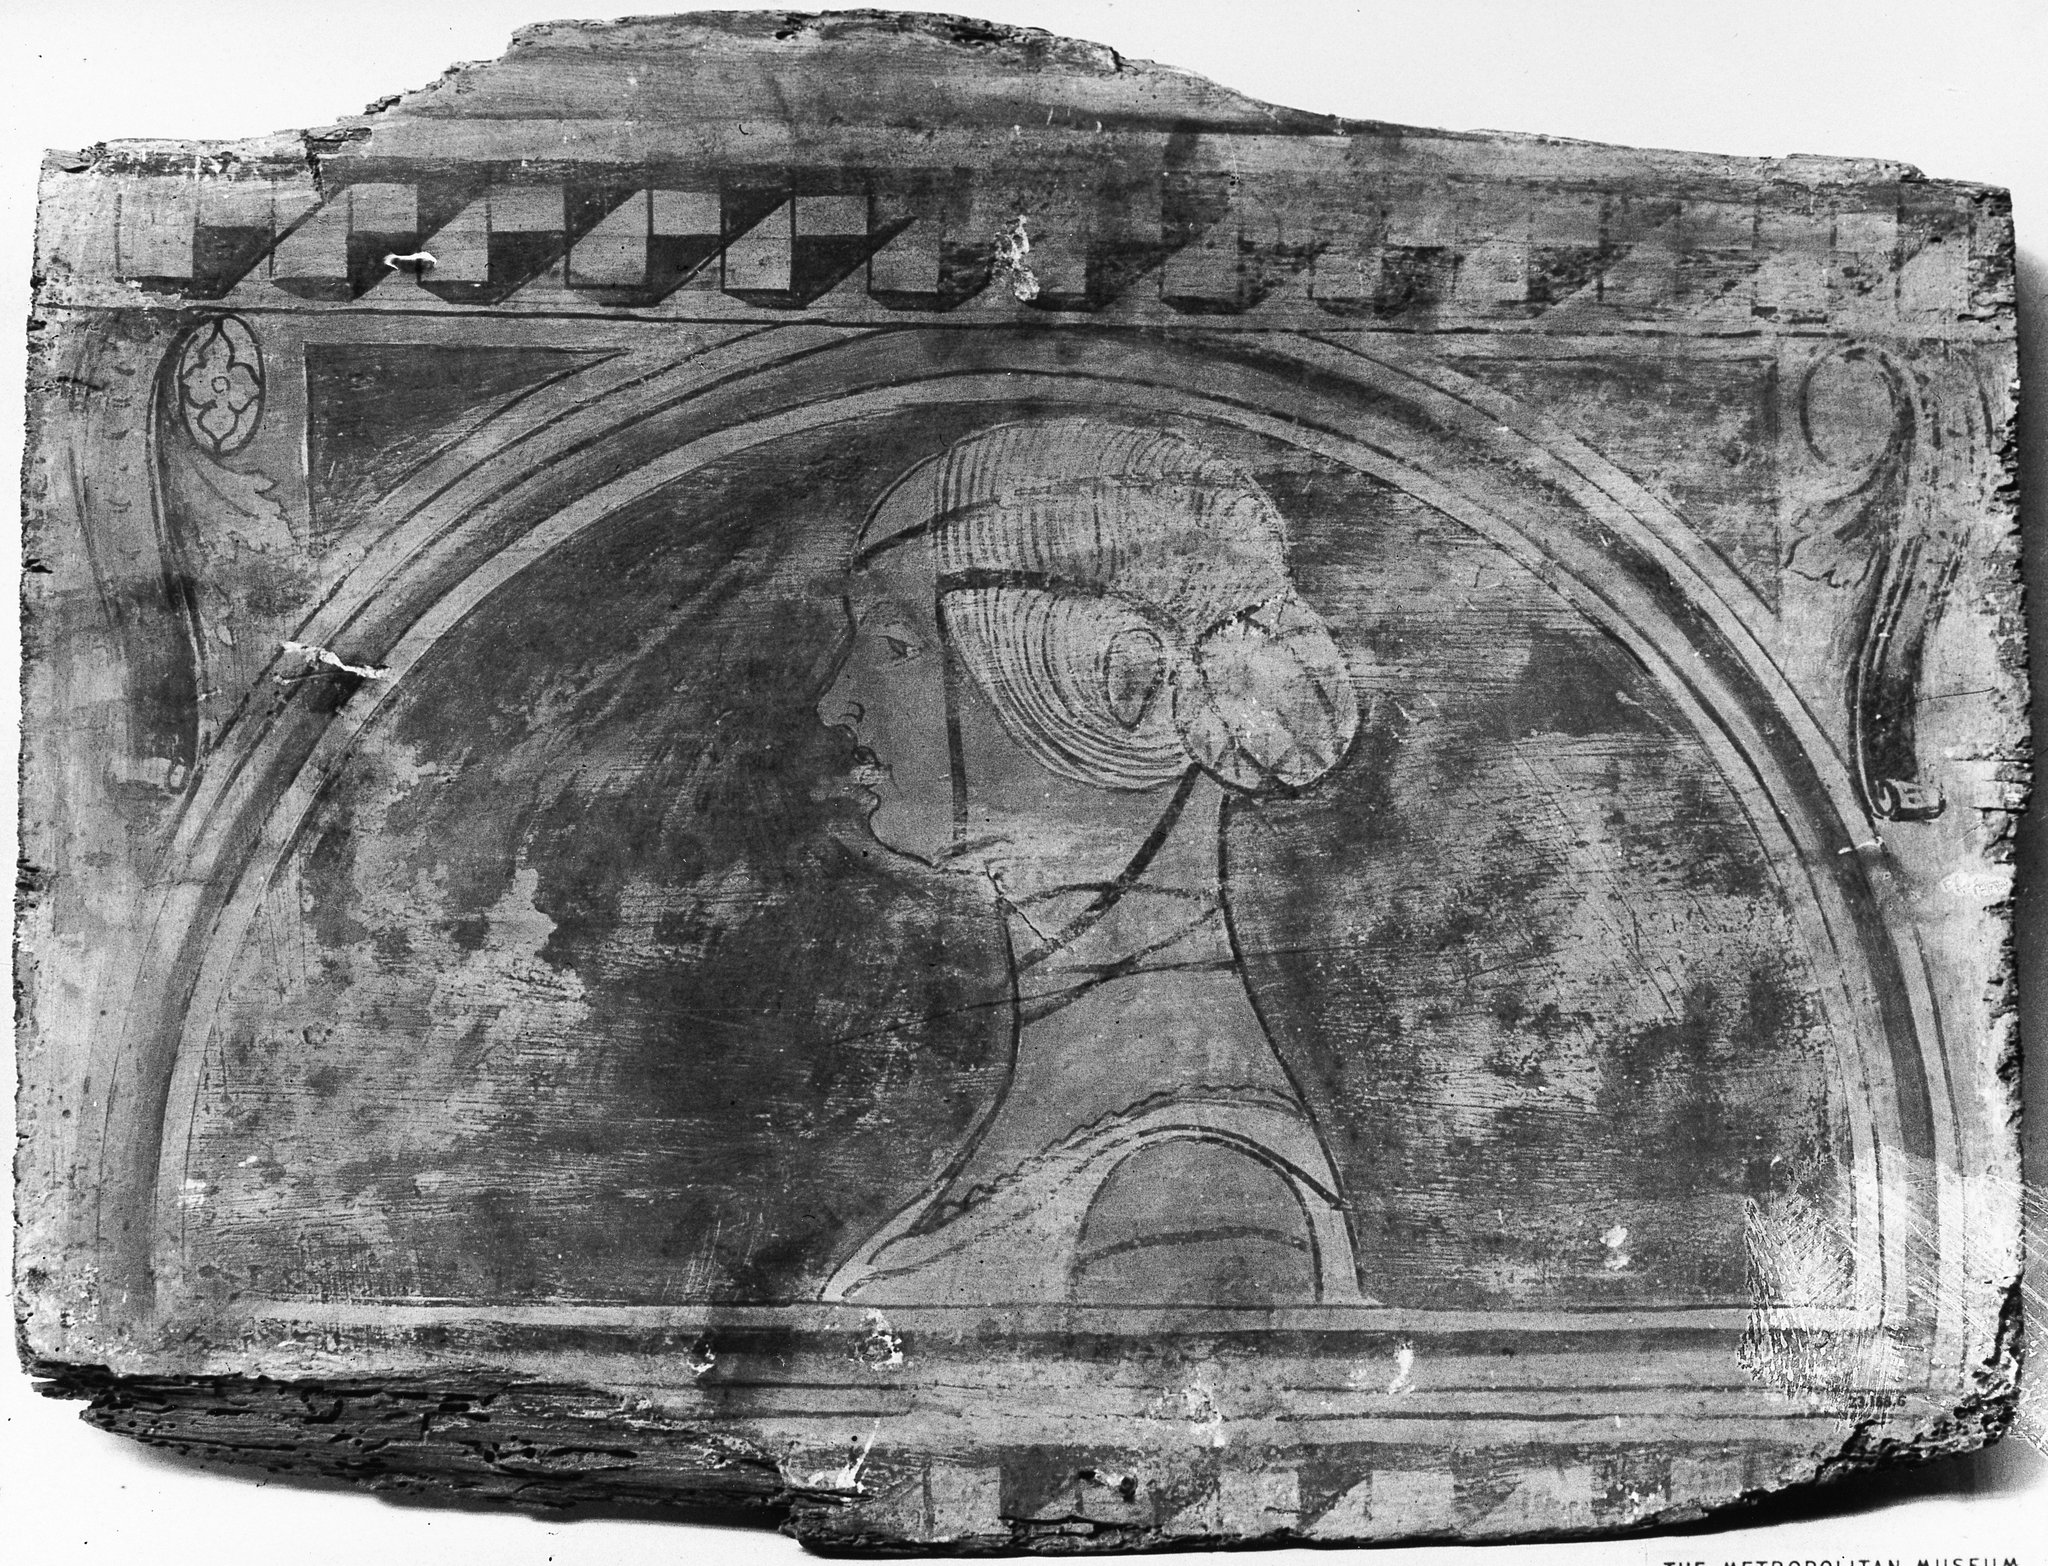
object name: frieze panel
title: Head of a woman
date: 1501-1533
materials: paint, wood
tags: profiles,women